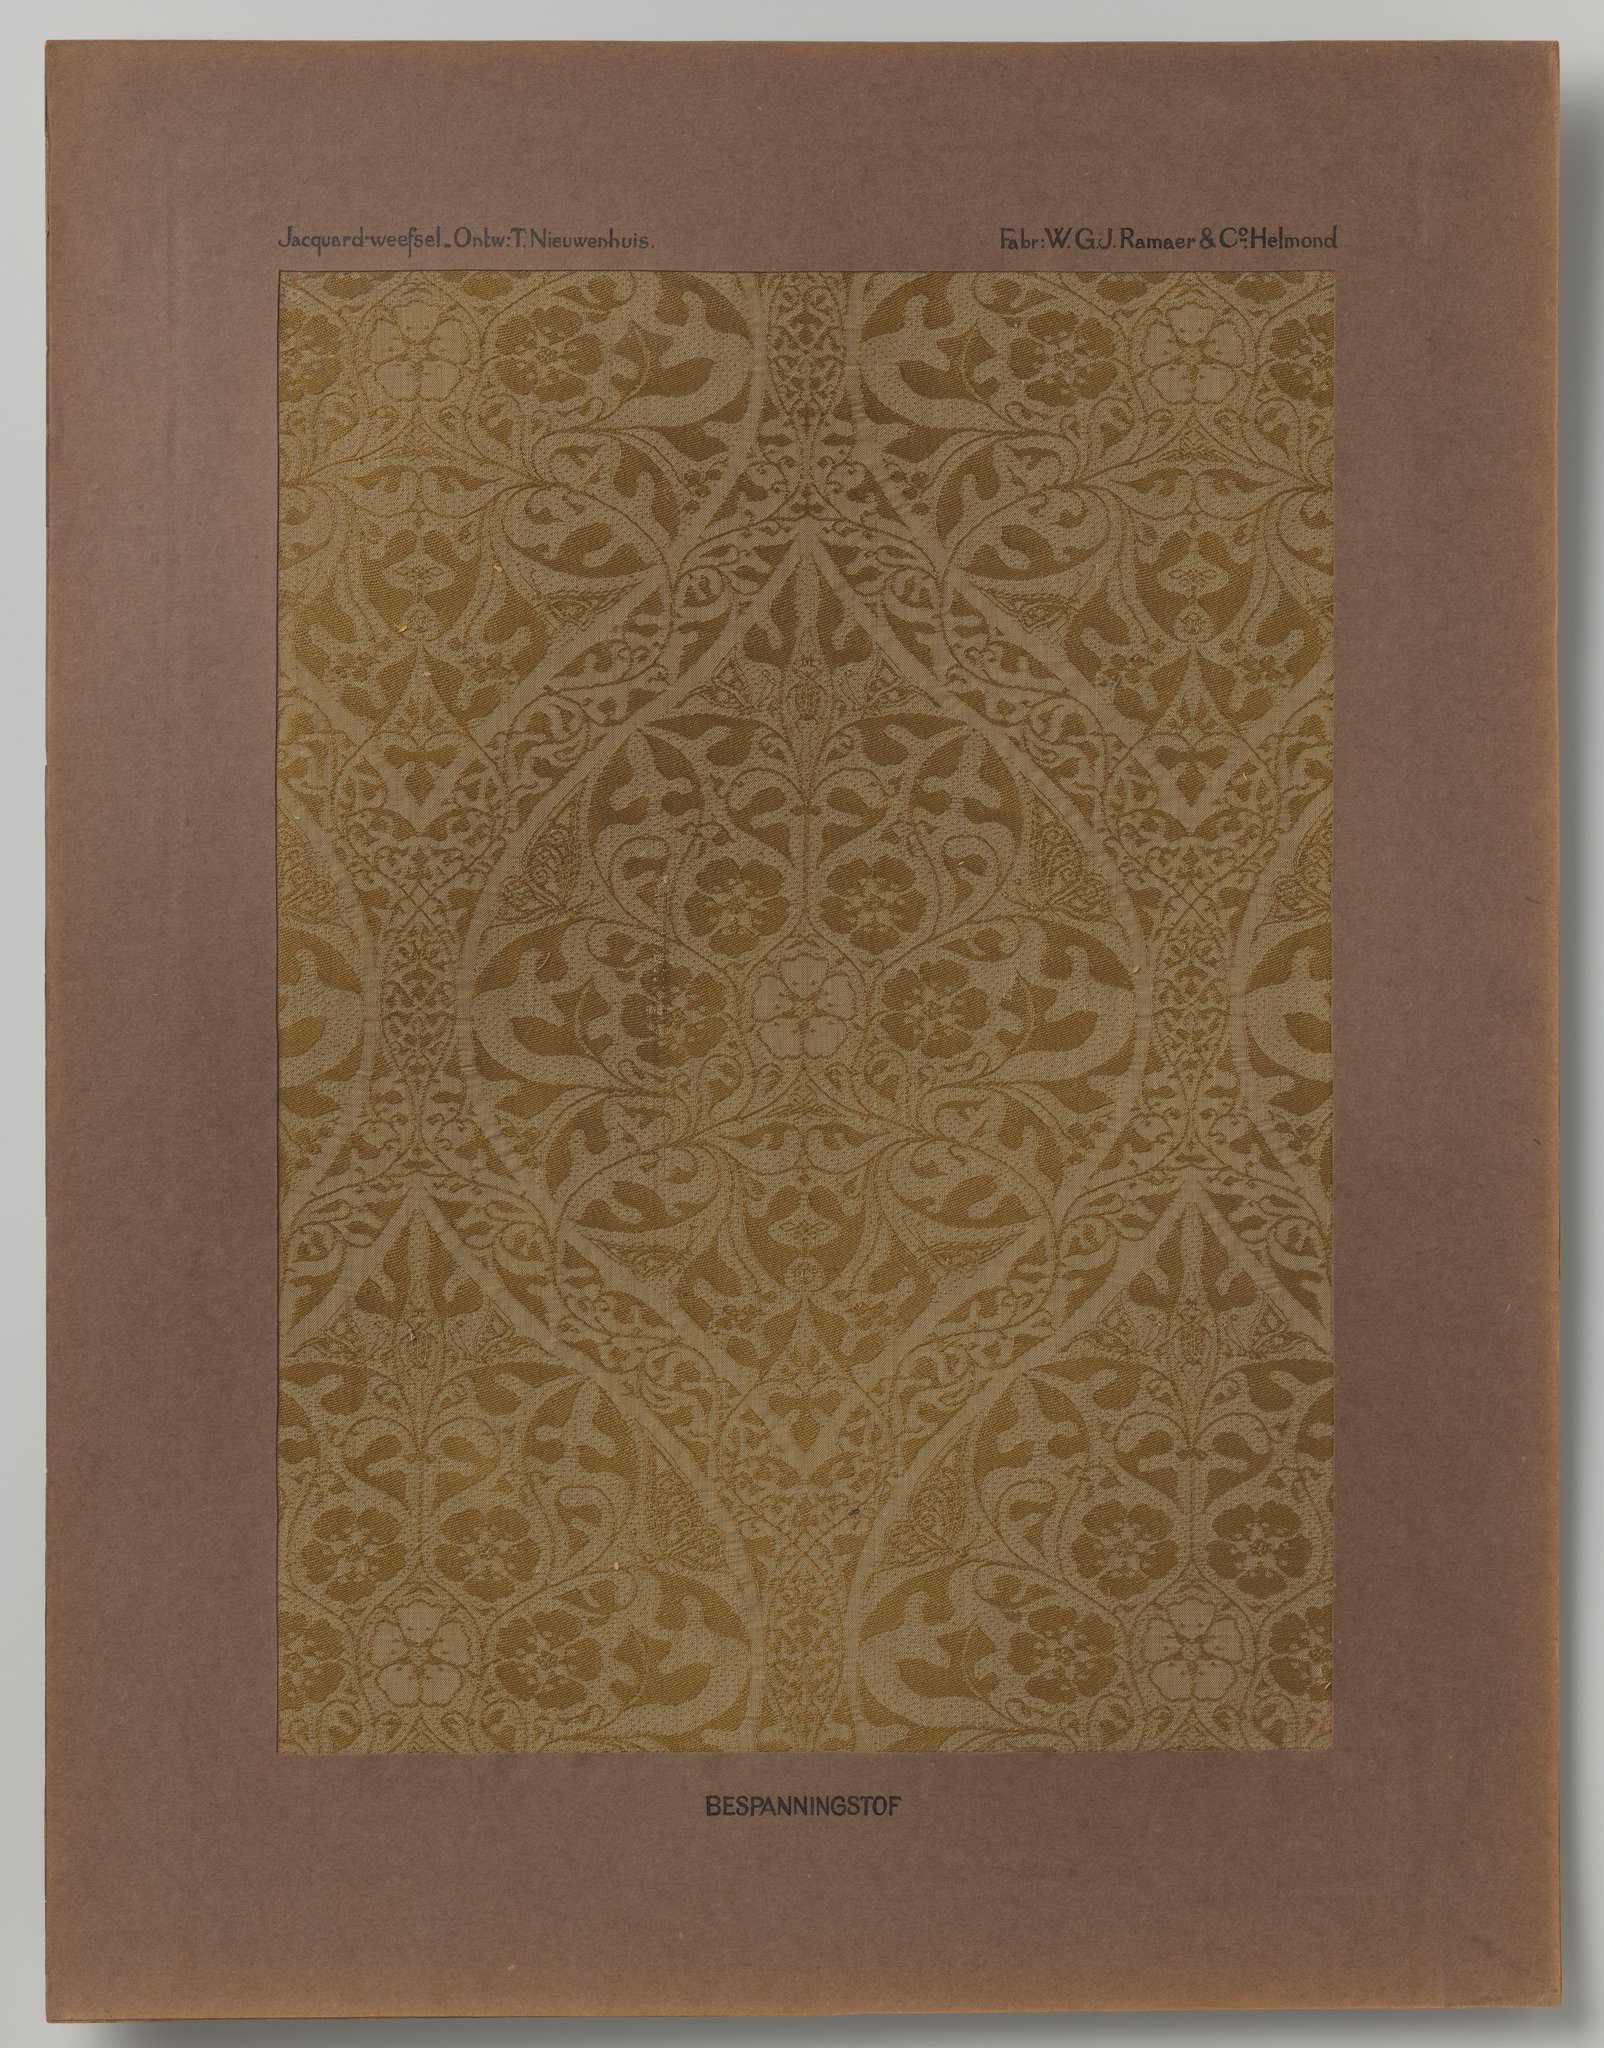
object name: upholstery fabric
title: Staal bespanningsstof naar ontwerp van Theo Nieuwenhuis in passe-partout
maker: theo nieuwenhuis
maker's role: designer, draughtsman, print maker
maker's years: 1866-1951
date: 1910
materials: cardboard, cotton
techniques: jacquard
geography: netherlands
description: Staal bespanningsstof van jacquardgeweven katoen naar ontwerp van Theo Nieuwenhuis. Floraal motief in spitsovaal, olijfgroene inslag op geelgroene ketting. In origineel passe-partout.